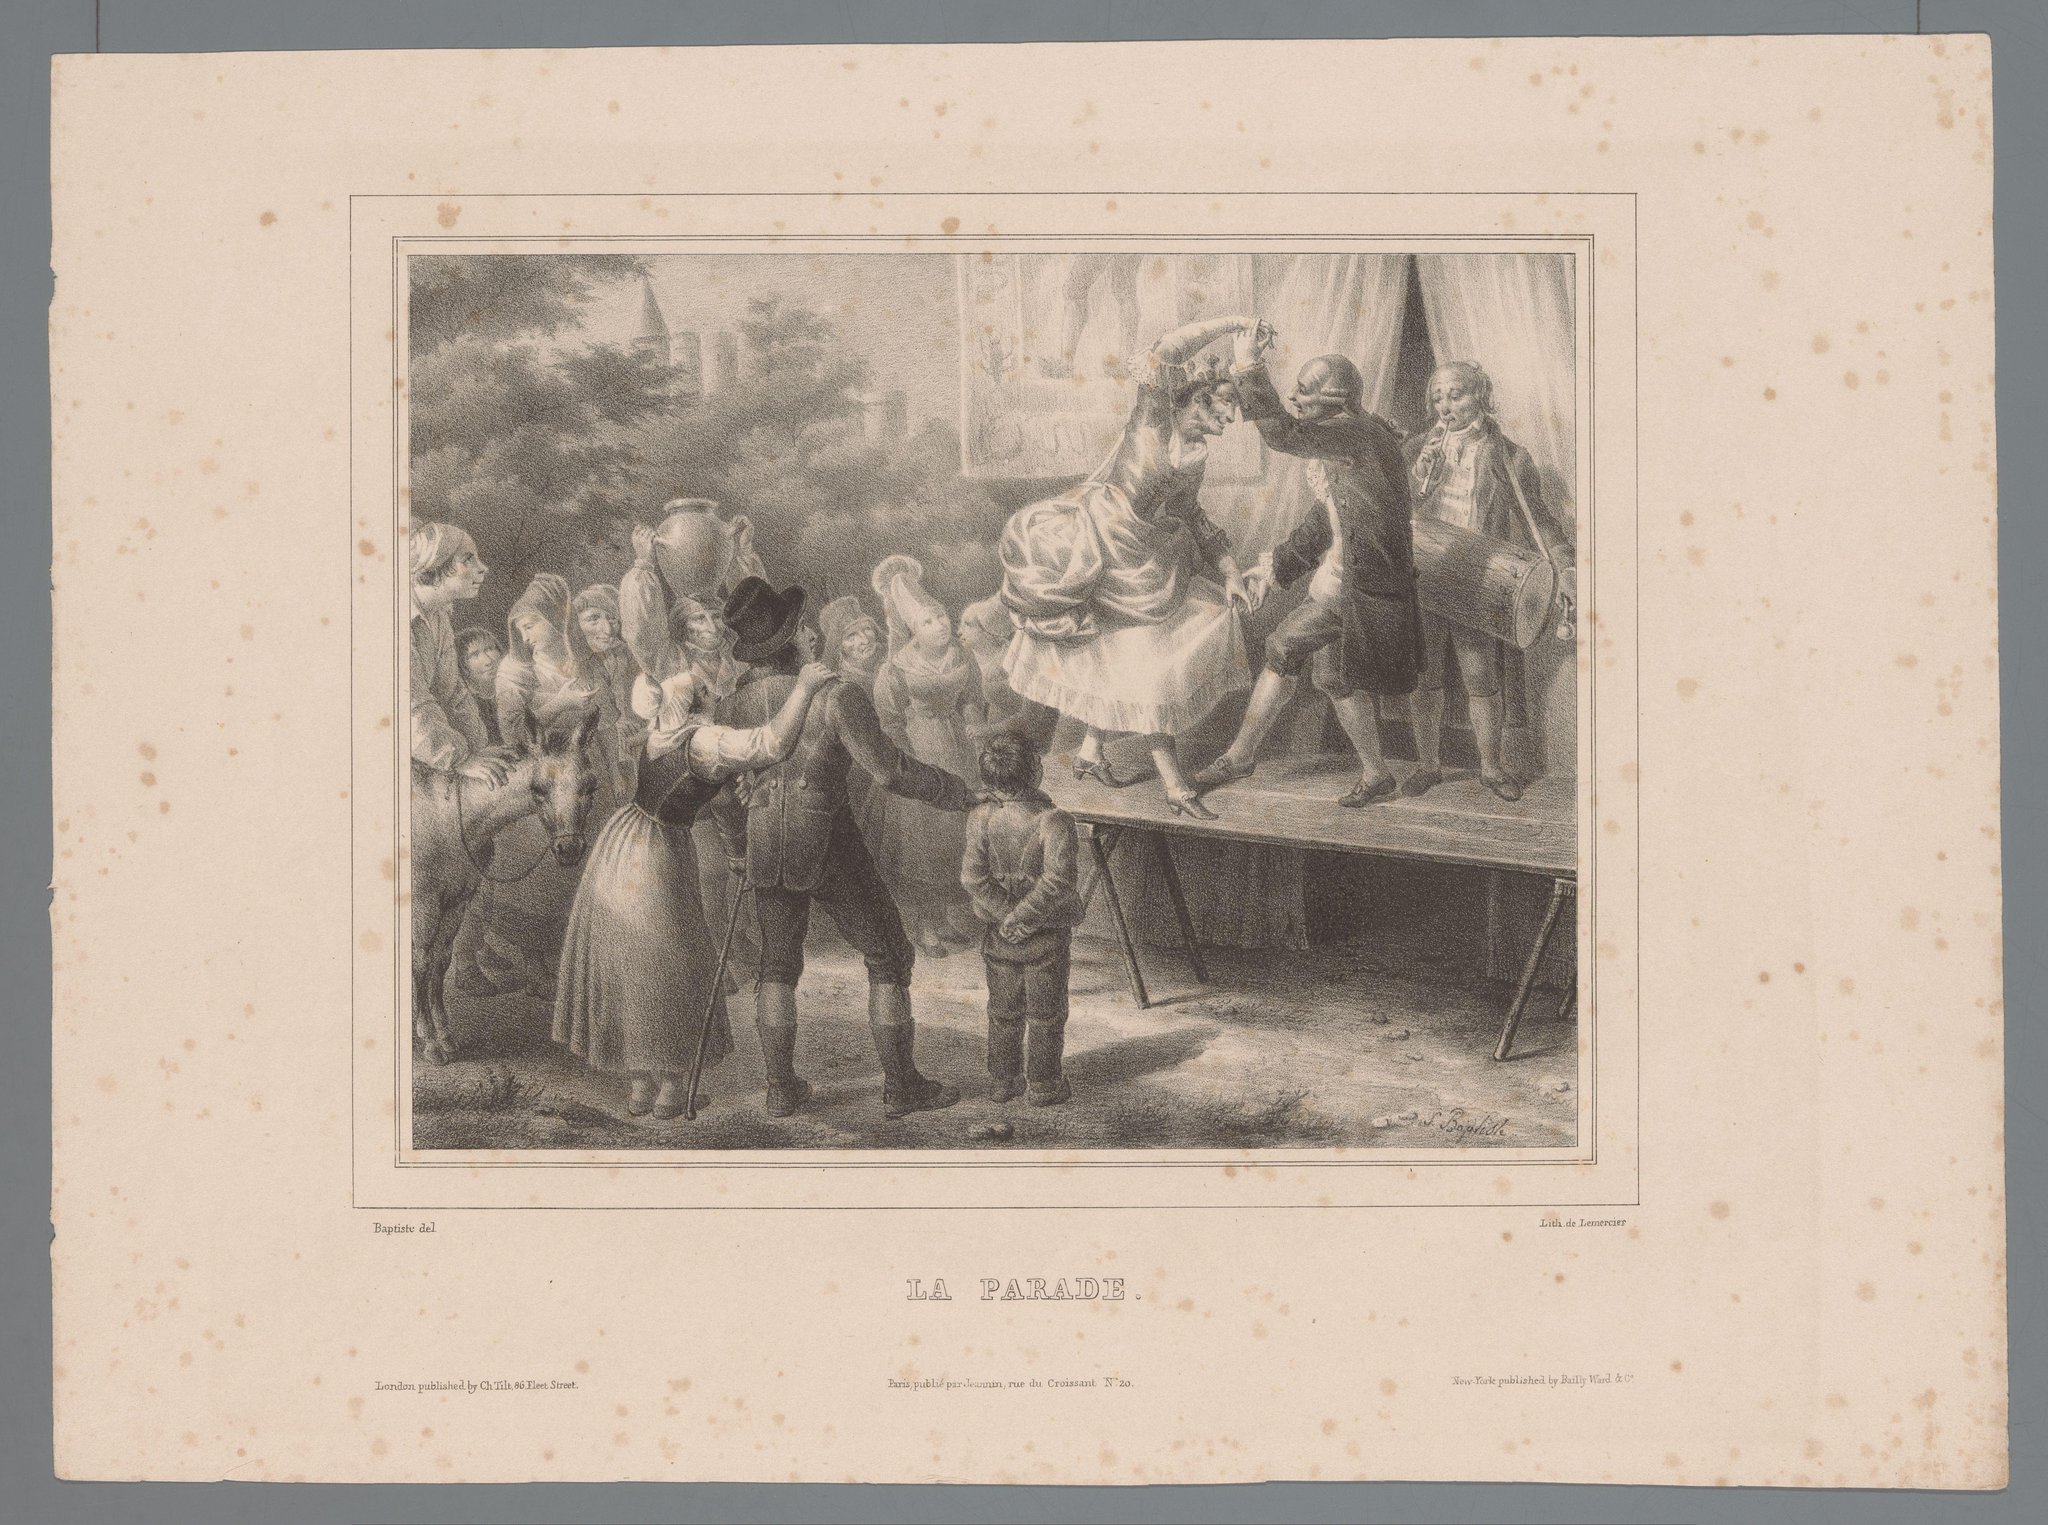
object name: print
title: Scènes populaires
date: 1833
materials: paper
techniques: lithography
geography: paris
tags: public festivities, comedy, satyr play, farce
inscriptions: collector's mark: Lugt 2228a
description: Deze prent maakt deel uit van een omslag met zes prenten.